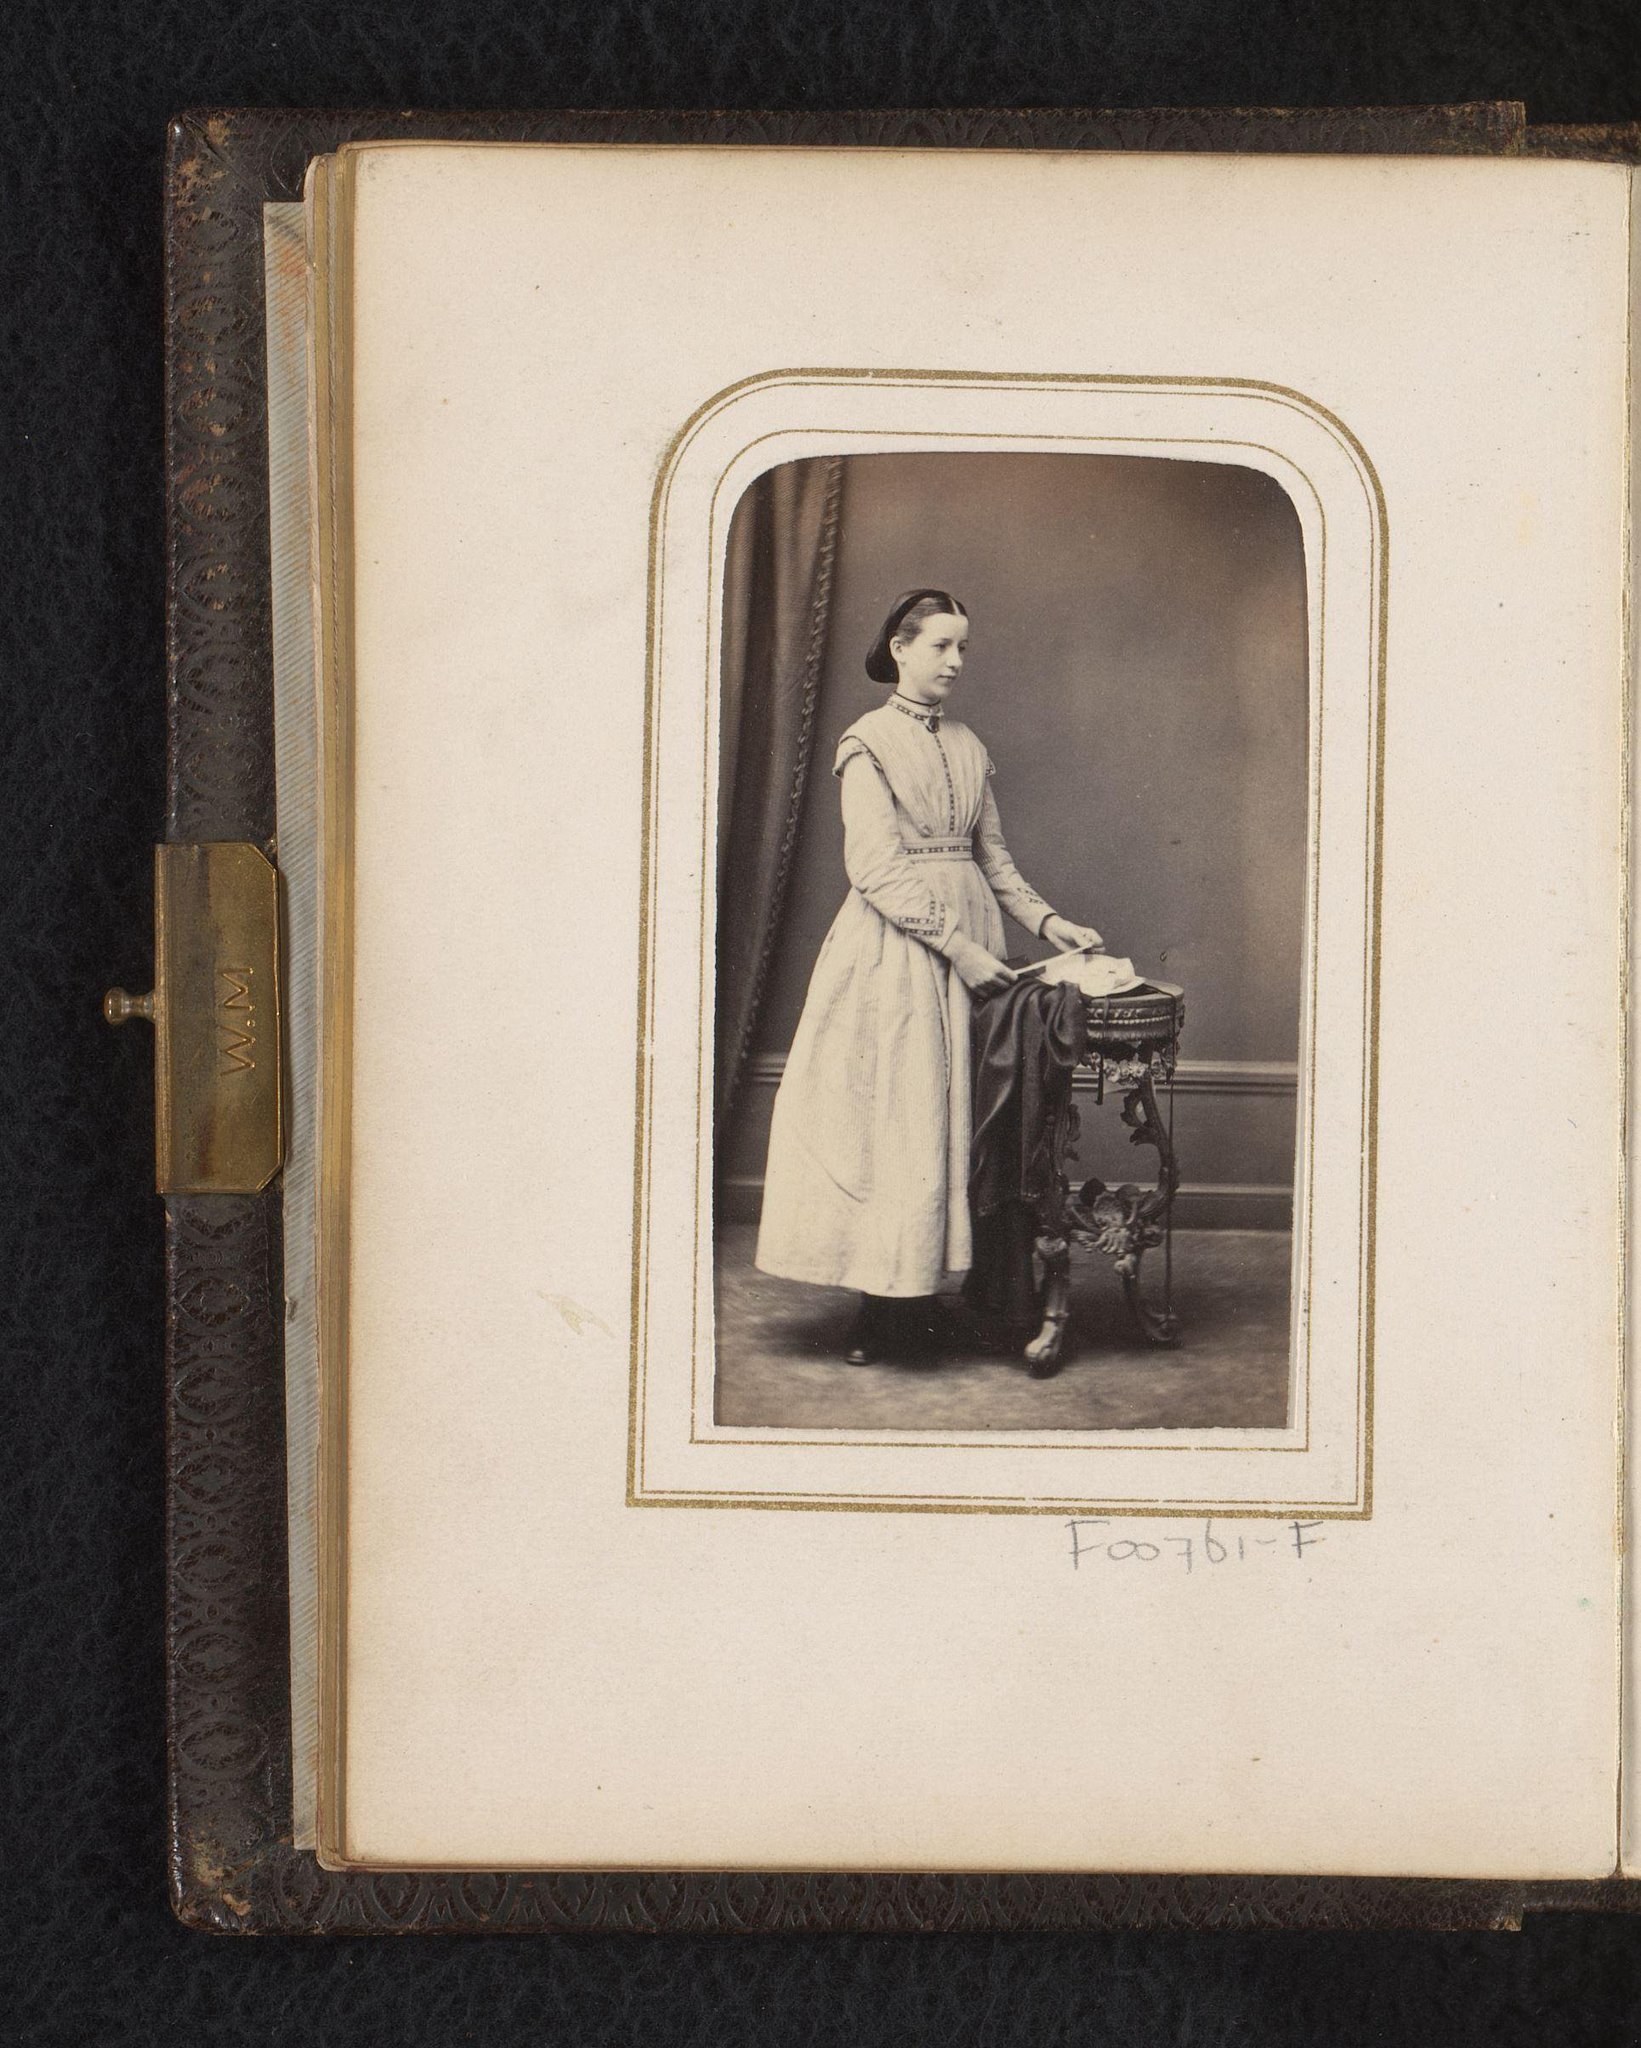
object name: photograph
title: Portret van een jonge vrouw, staand bij een tafel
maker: o.c. smith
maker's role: fotograaf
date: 1860-1890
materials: cardboard, photographic support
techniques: albumen print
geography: stroud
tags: historical persons - bb - woman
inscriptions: inscription: ‘O.C. Smith/ Landsdown/ Stroud’